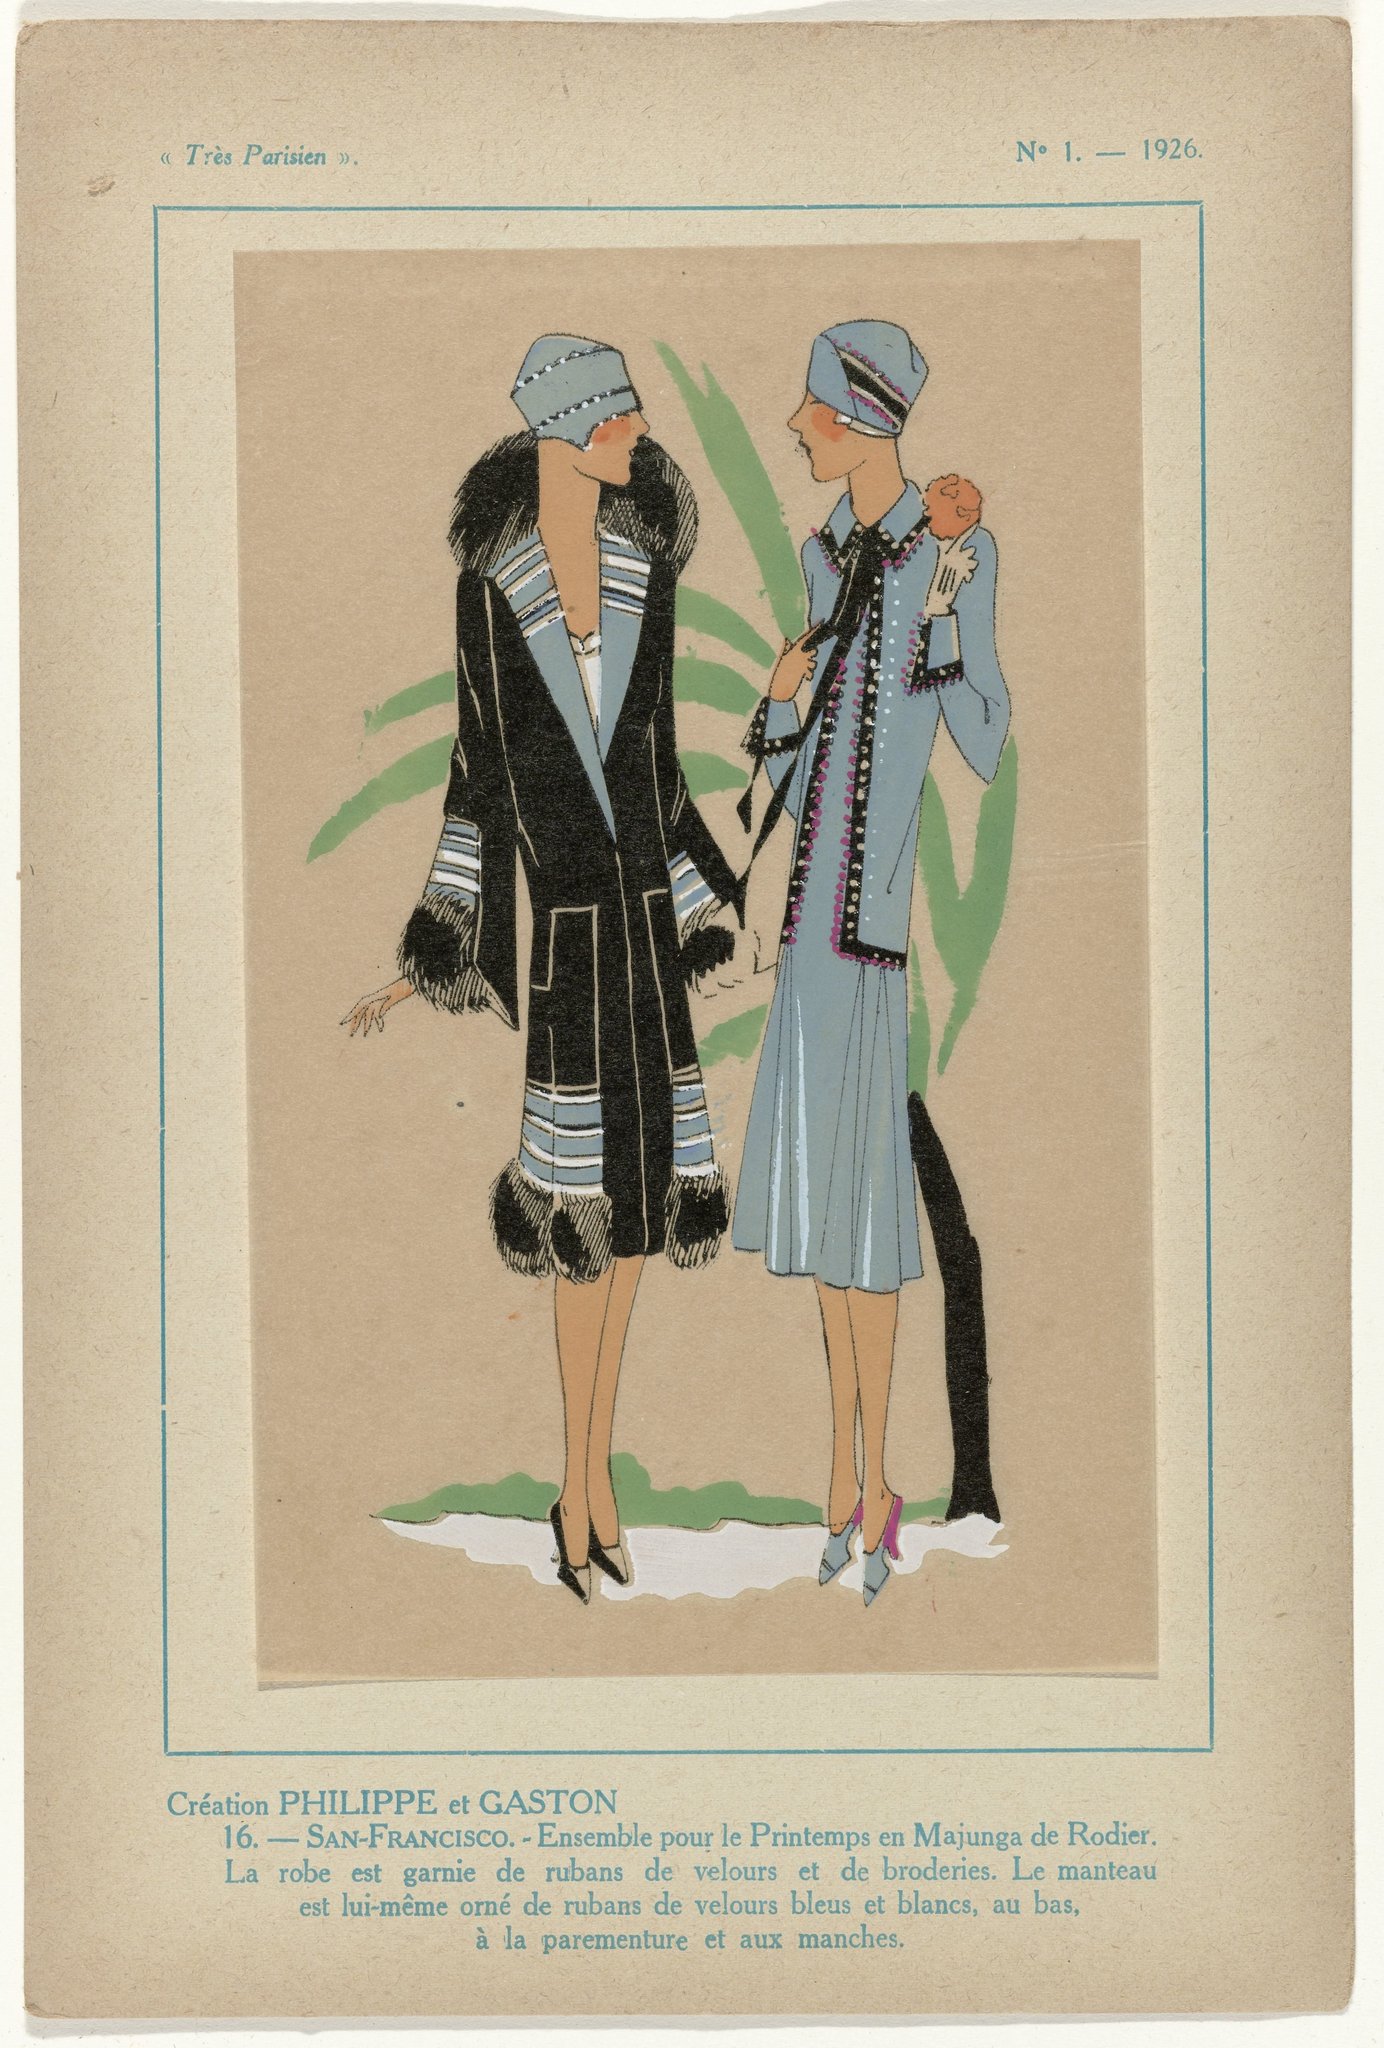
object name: fashion print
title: Très Parisien, 1926, No. 1, Pl. 16: Création PHILIPPE et GASTON - SAN-FRANCISCO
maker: g-p. joumard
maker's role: publisher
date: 1926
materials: paper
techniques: hand coloring, letterpress printing, lithography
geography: paris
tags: ensemble of pieces of clothing (+ women's clothes), coat (+ women's clothes), fashion plates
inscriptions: date: ‘Ensemble pour le Printemps en Majunga de Rodier. La robe est garnie de rubans de velours et de broderies. Le manteau est lui-même orné de rubans de velours bleus et blancs, au bas, à la parementure et aux manches.’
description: Twee creaties van het modehuis Philippe et Gaston. Ensemble voor de lente. Japon gegarneerd met borduurwerk en linten van fluweel. Mantel gegarneerd met linten van wit en blauw fluweel, afgezet met bont. Prent uit het modetijdschrift Très Parisien... La Mode, Le Chic, L'Élegance (1920-1936)